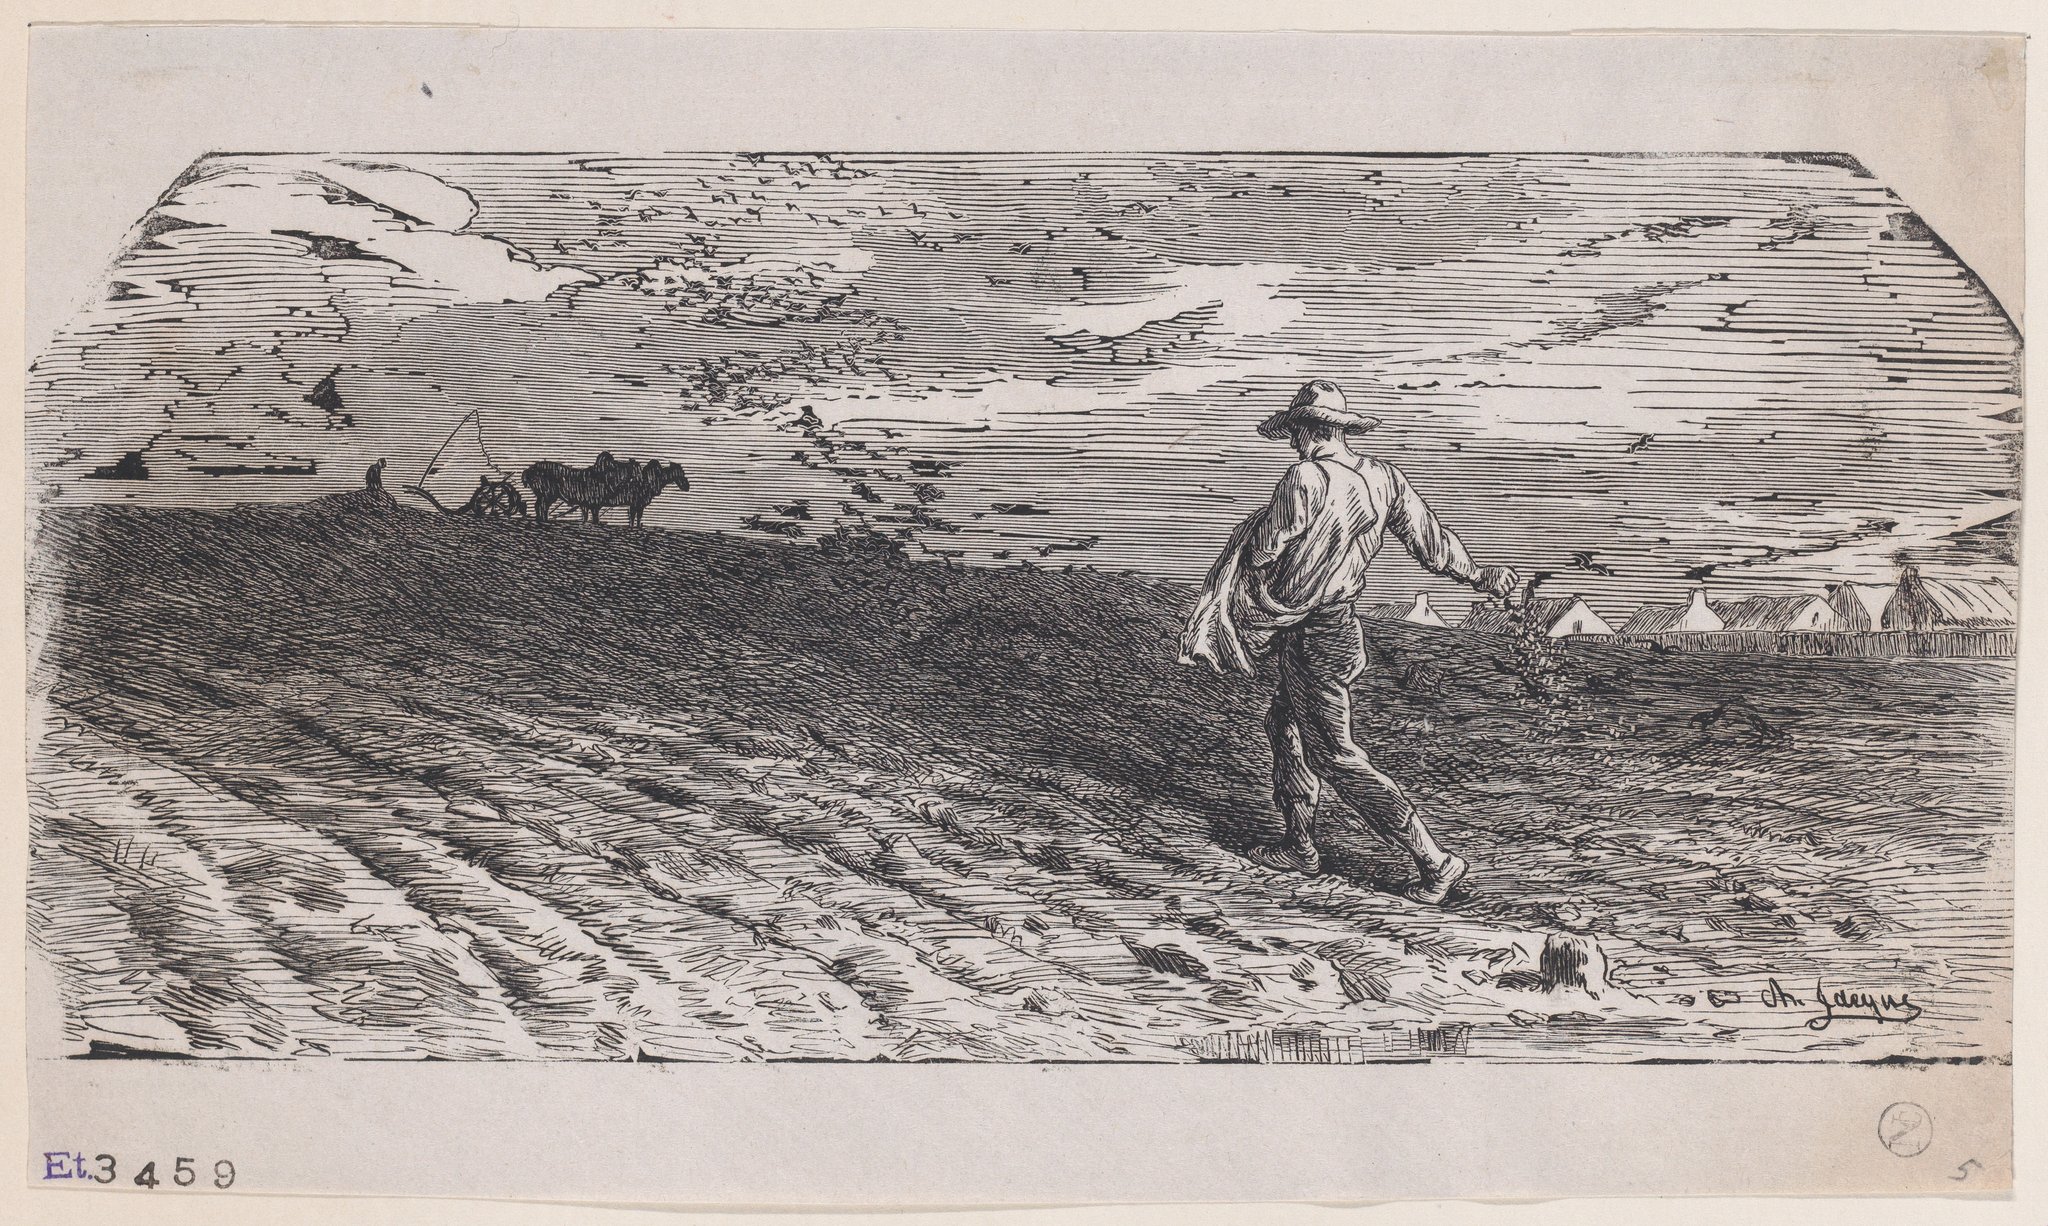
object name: print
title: The Sower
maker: charles émile jacque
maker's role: artist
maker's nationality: french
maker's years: 1813-1894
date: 1852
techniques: engraving